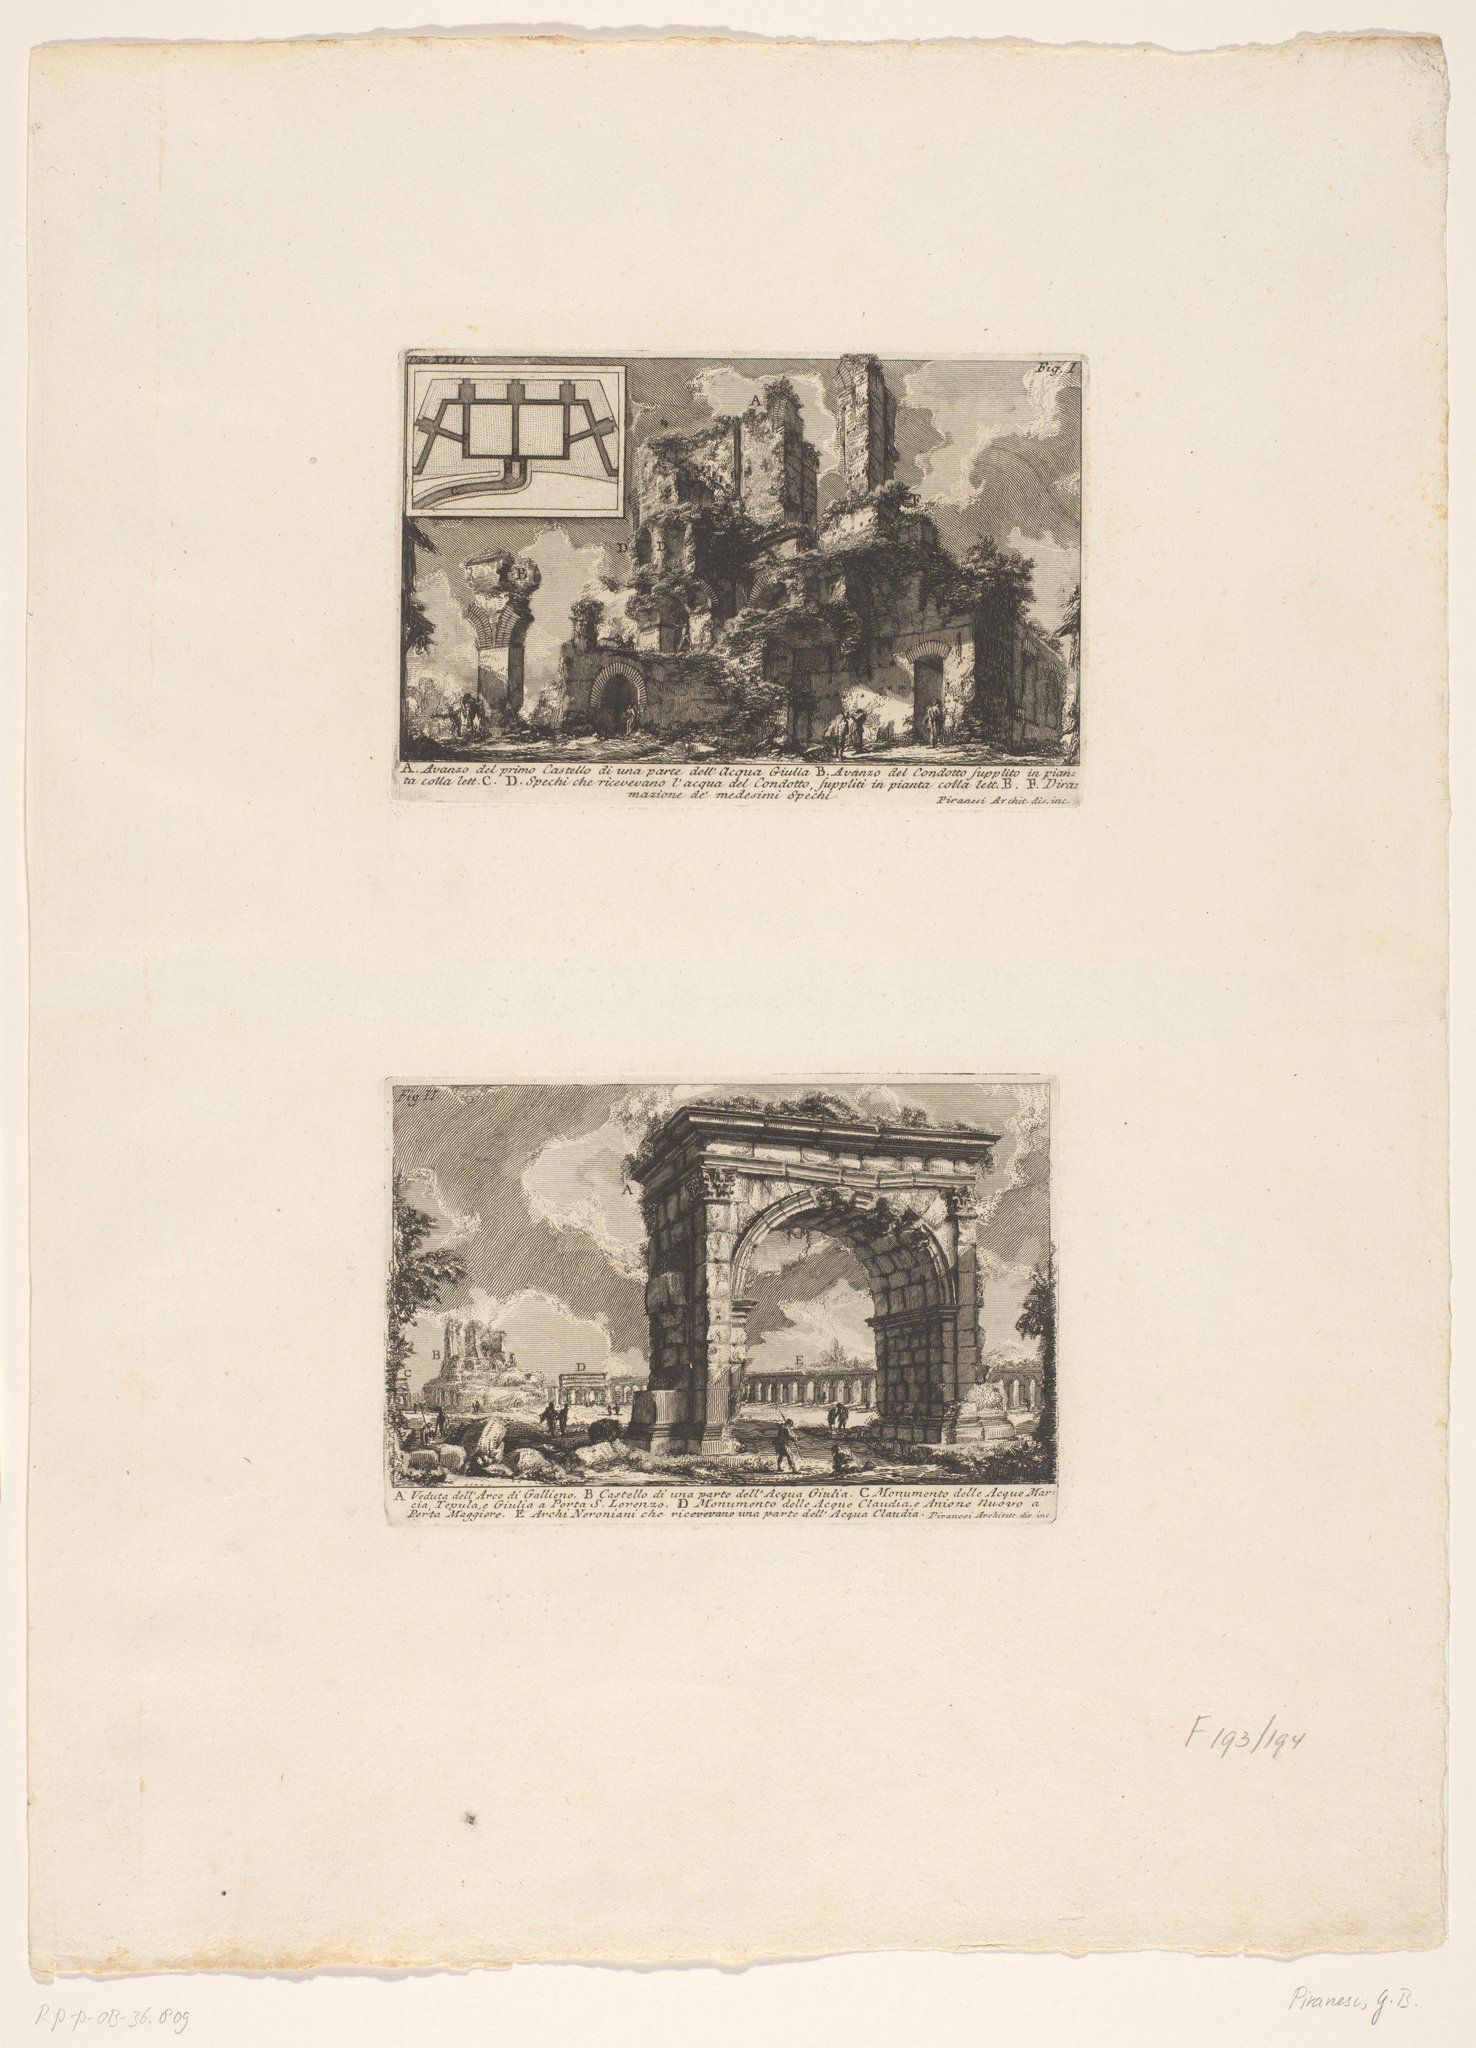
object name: print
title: Restanten van de Aqua Iulia en Boog van Gallienus te Rome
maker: giovanni battista piranesi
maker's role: designer, draughtsman, print maker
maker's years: 1720-1778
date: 1756-1757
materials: paper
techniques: etching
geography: rome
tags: ruin of a building ~ architecture, triumphal arch, aqueduct (~ water supply)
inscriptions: collector's mark: Lugt 2228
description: Blad met twee voorstellingen van Romeinse bouwwerken. Boven: restanten van het aquaduct Aqua Iulia. Een plattegrond en genummerd linksboven: Tav. XXVI. Genummerd rechtsboven: Fig. I. Verklarende lijst met letters in ondermarge. Onder: de Boog van Gallienus met rechts de Arcus Neroniani, een aftakking van het aquaduct Aqua Claudia. In de verte de stadspoort Porta Maggiore. Genummerd linksboven: Fig. II. Verklarende lijst met letters in ondermarge.